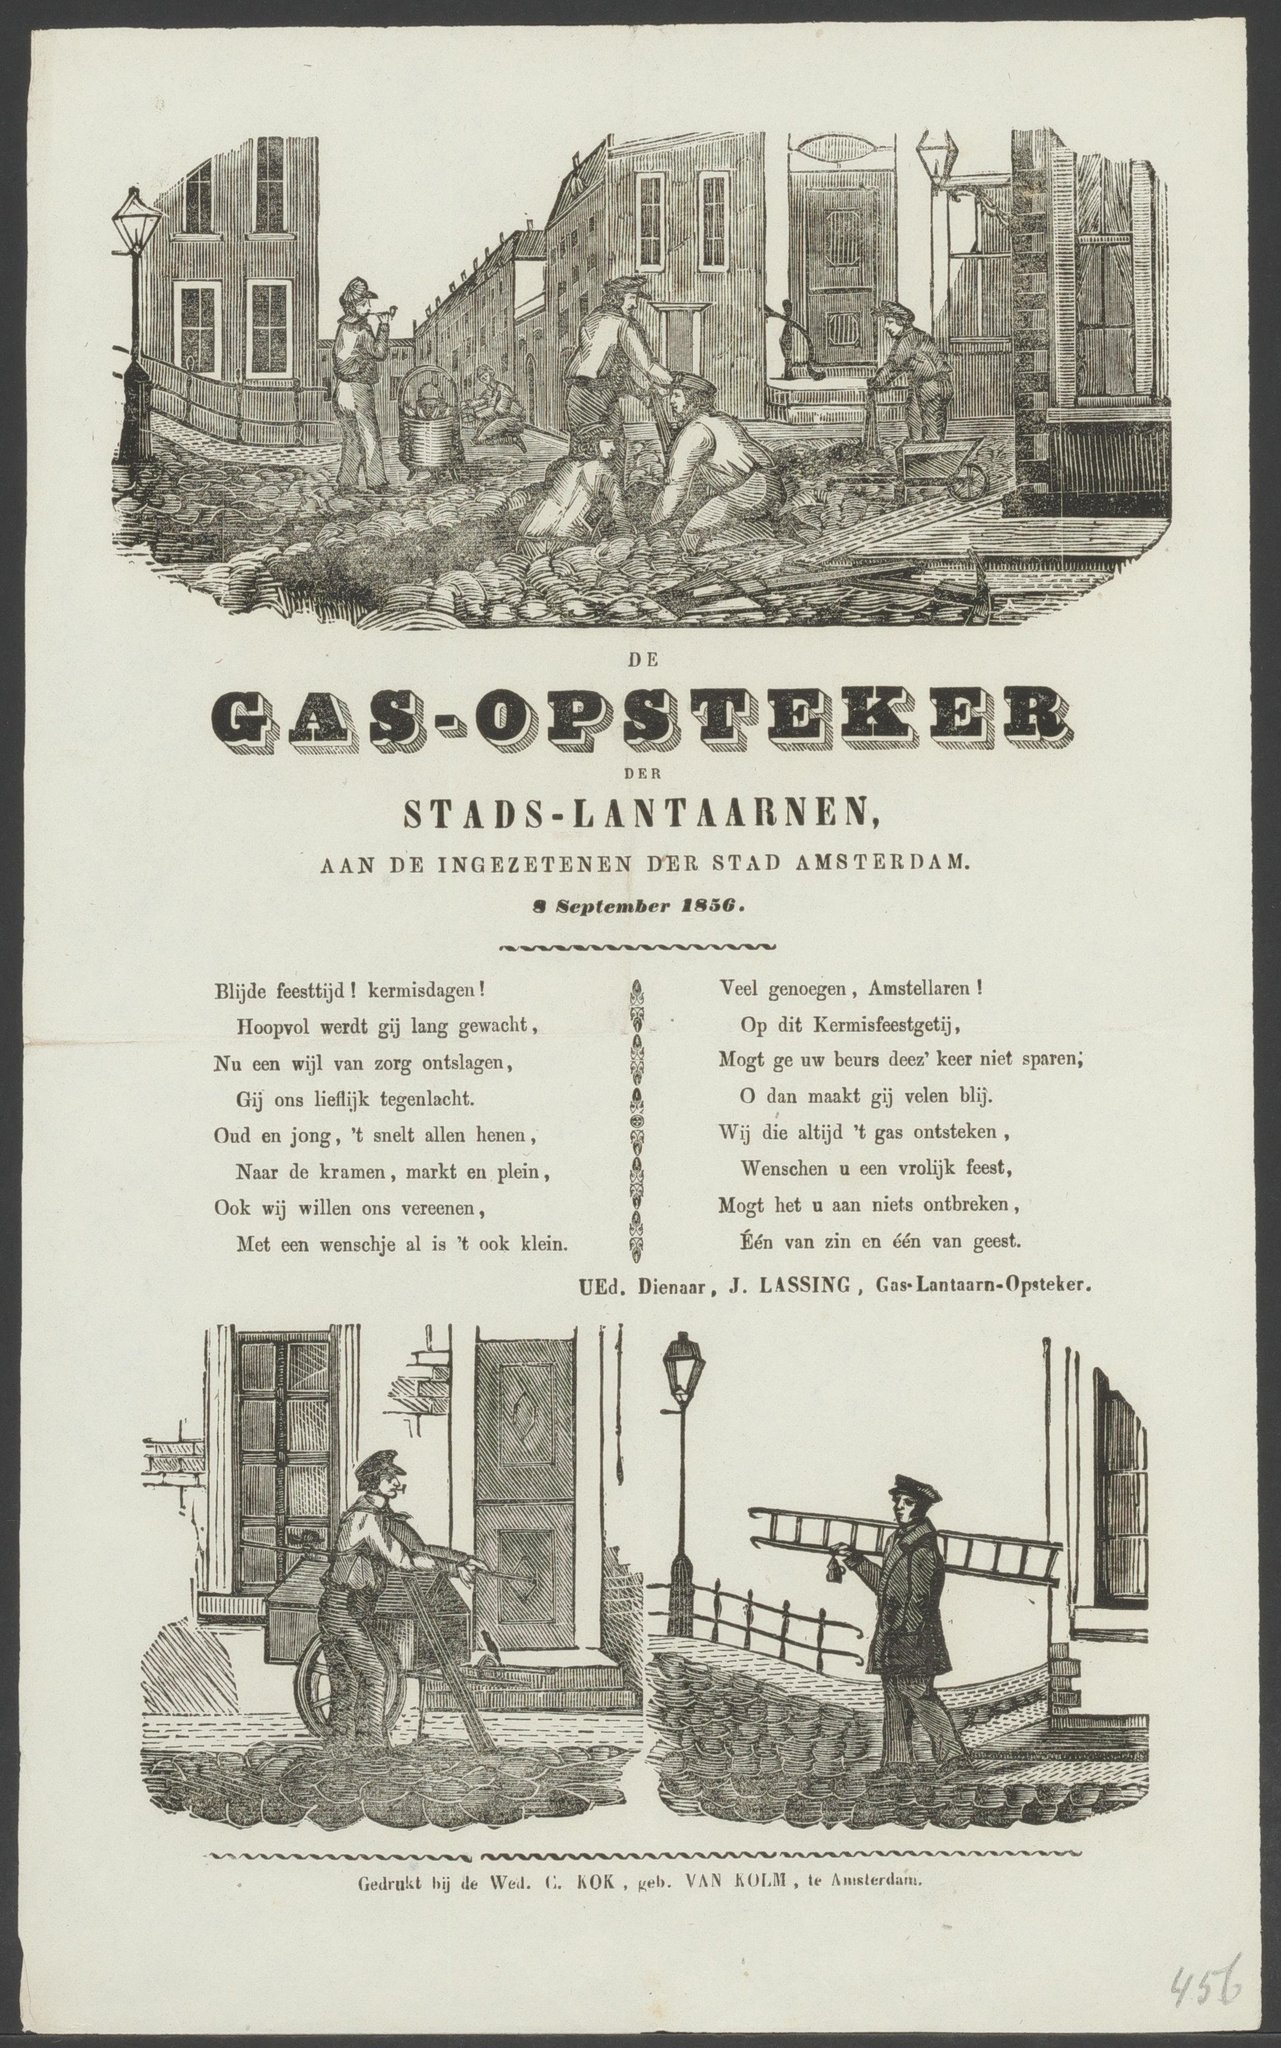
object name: fair print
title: Kermiswens van de gaslantaarnopstekers van Amsterdam voor het jaar 1856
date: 1856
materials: paper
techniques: letterpress printing, engraving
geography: amsterdam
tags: gas-lamp, gas supply, digging (industrial process), street lighting, amsterdam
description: Kermiswens van de Amsterdamse gaslantaarnopstekers voor het jaar 1856. Centraal een vers in twee kolommen. Bovenaan een straat in Amsterdam opgebroken voor de aanleg van de gasleiding. Onderaan twee gasfitters. Van de gaslantaarnopsteker: J. Lassing. Onderwerpsrubrieken binnen de Atlas Zeden en Gewoonten: Zeden en gewoonten in engeren zin, Volksleven, Volksbladen, Nieuwjaars- en Kerstwenschen, Amsterdam.